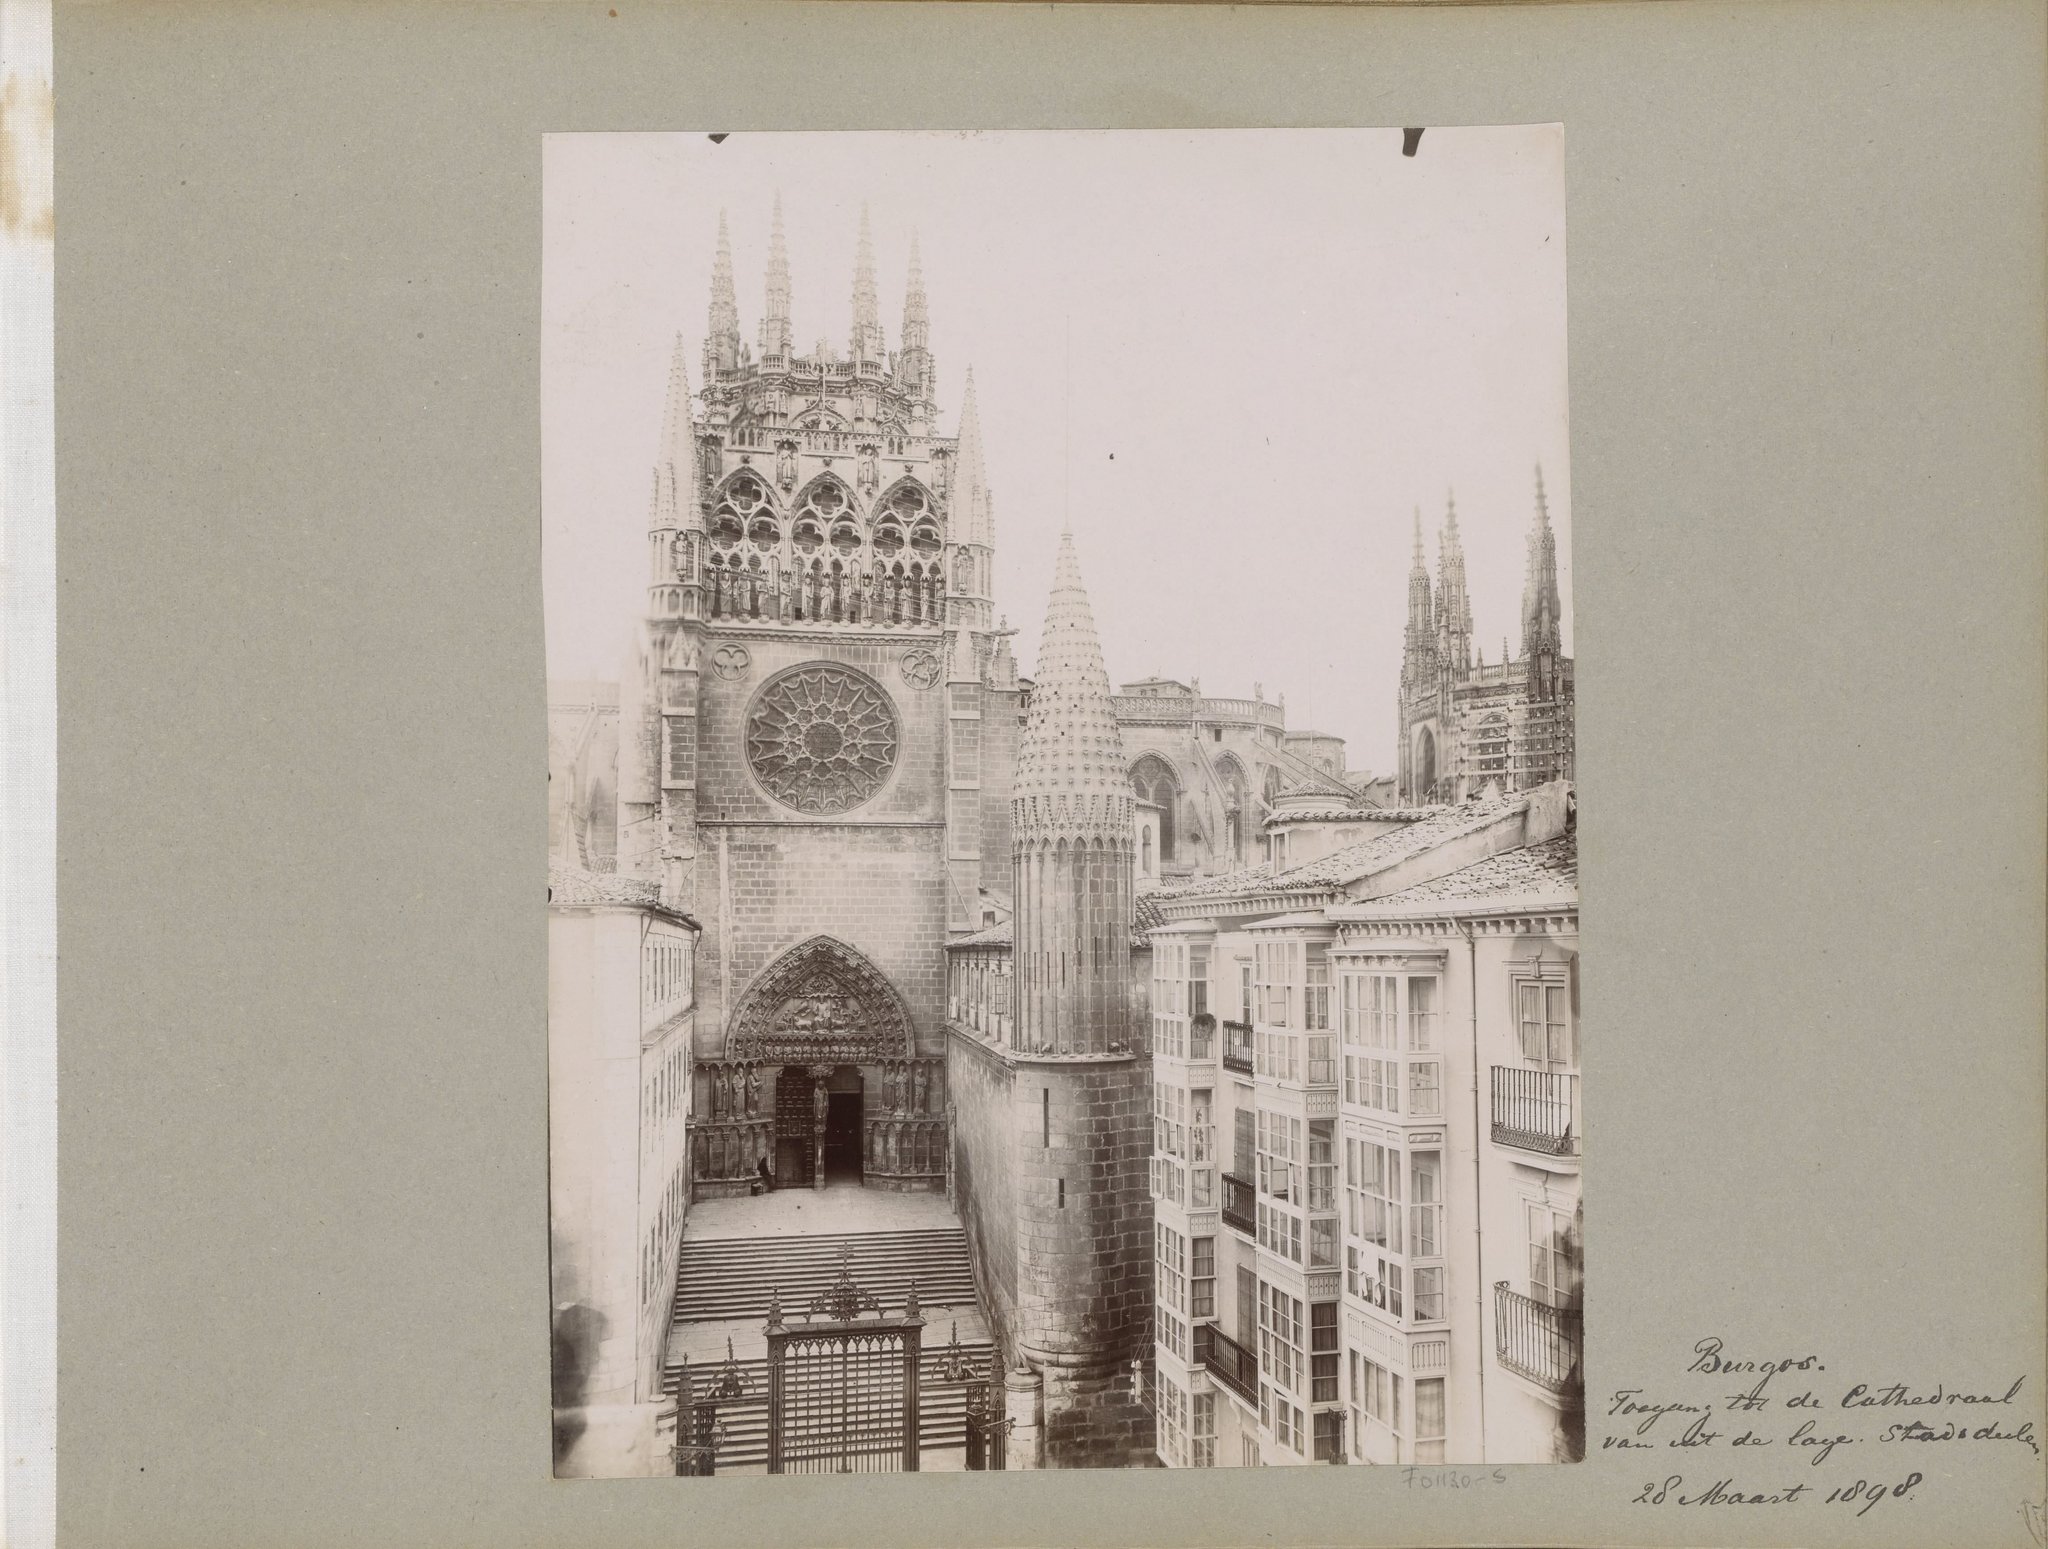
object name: photograph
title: Gezicht op de kathedraal van Burgos met trappen en omliggende huizen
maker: Anonymous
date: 1880-1898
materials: paper, photographic support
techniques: gelatin silver print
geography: burgos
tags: church (exterior)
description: Onderdeel van Reisalbum met foto's van bezienswaardigheden in Frankrijk, Spanje, Italië, Duitsland, Zwitserland en Oostenrijk.